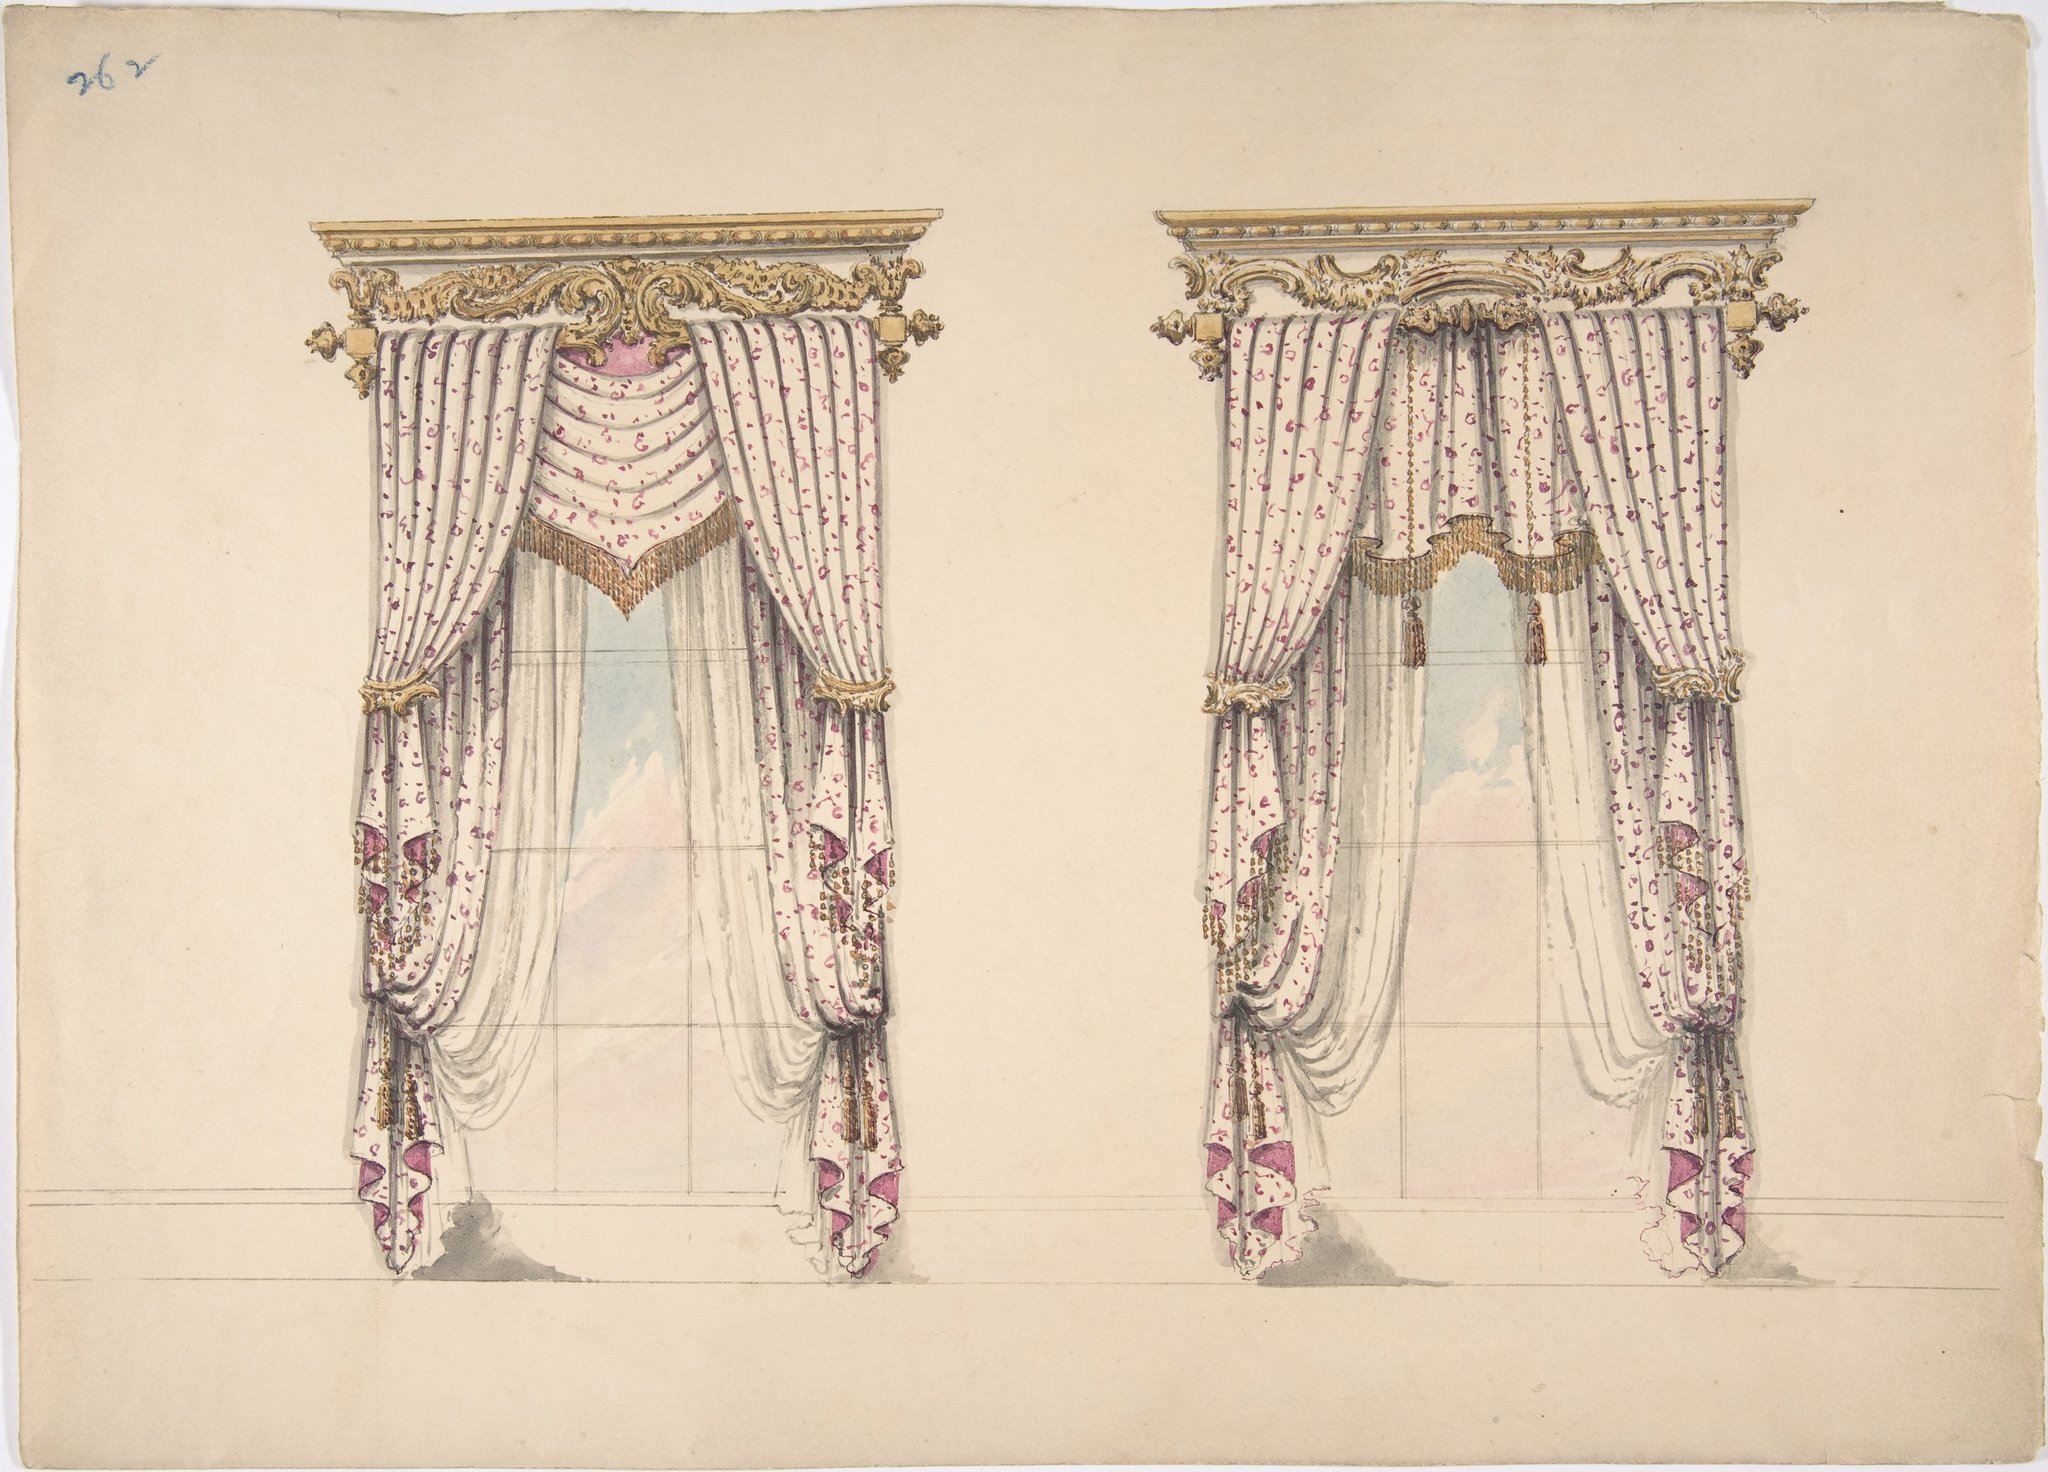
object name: drawing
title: Design for Pink and White Curtains with Gold Fringes, and Gold and White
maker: anonymous, british, 19th century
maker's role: artist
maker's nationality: british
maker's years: 1800-1900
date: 1801-1833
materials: ink, watercolor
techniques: brush, pen, wash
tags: curtains